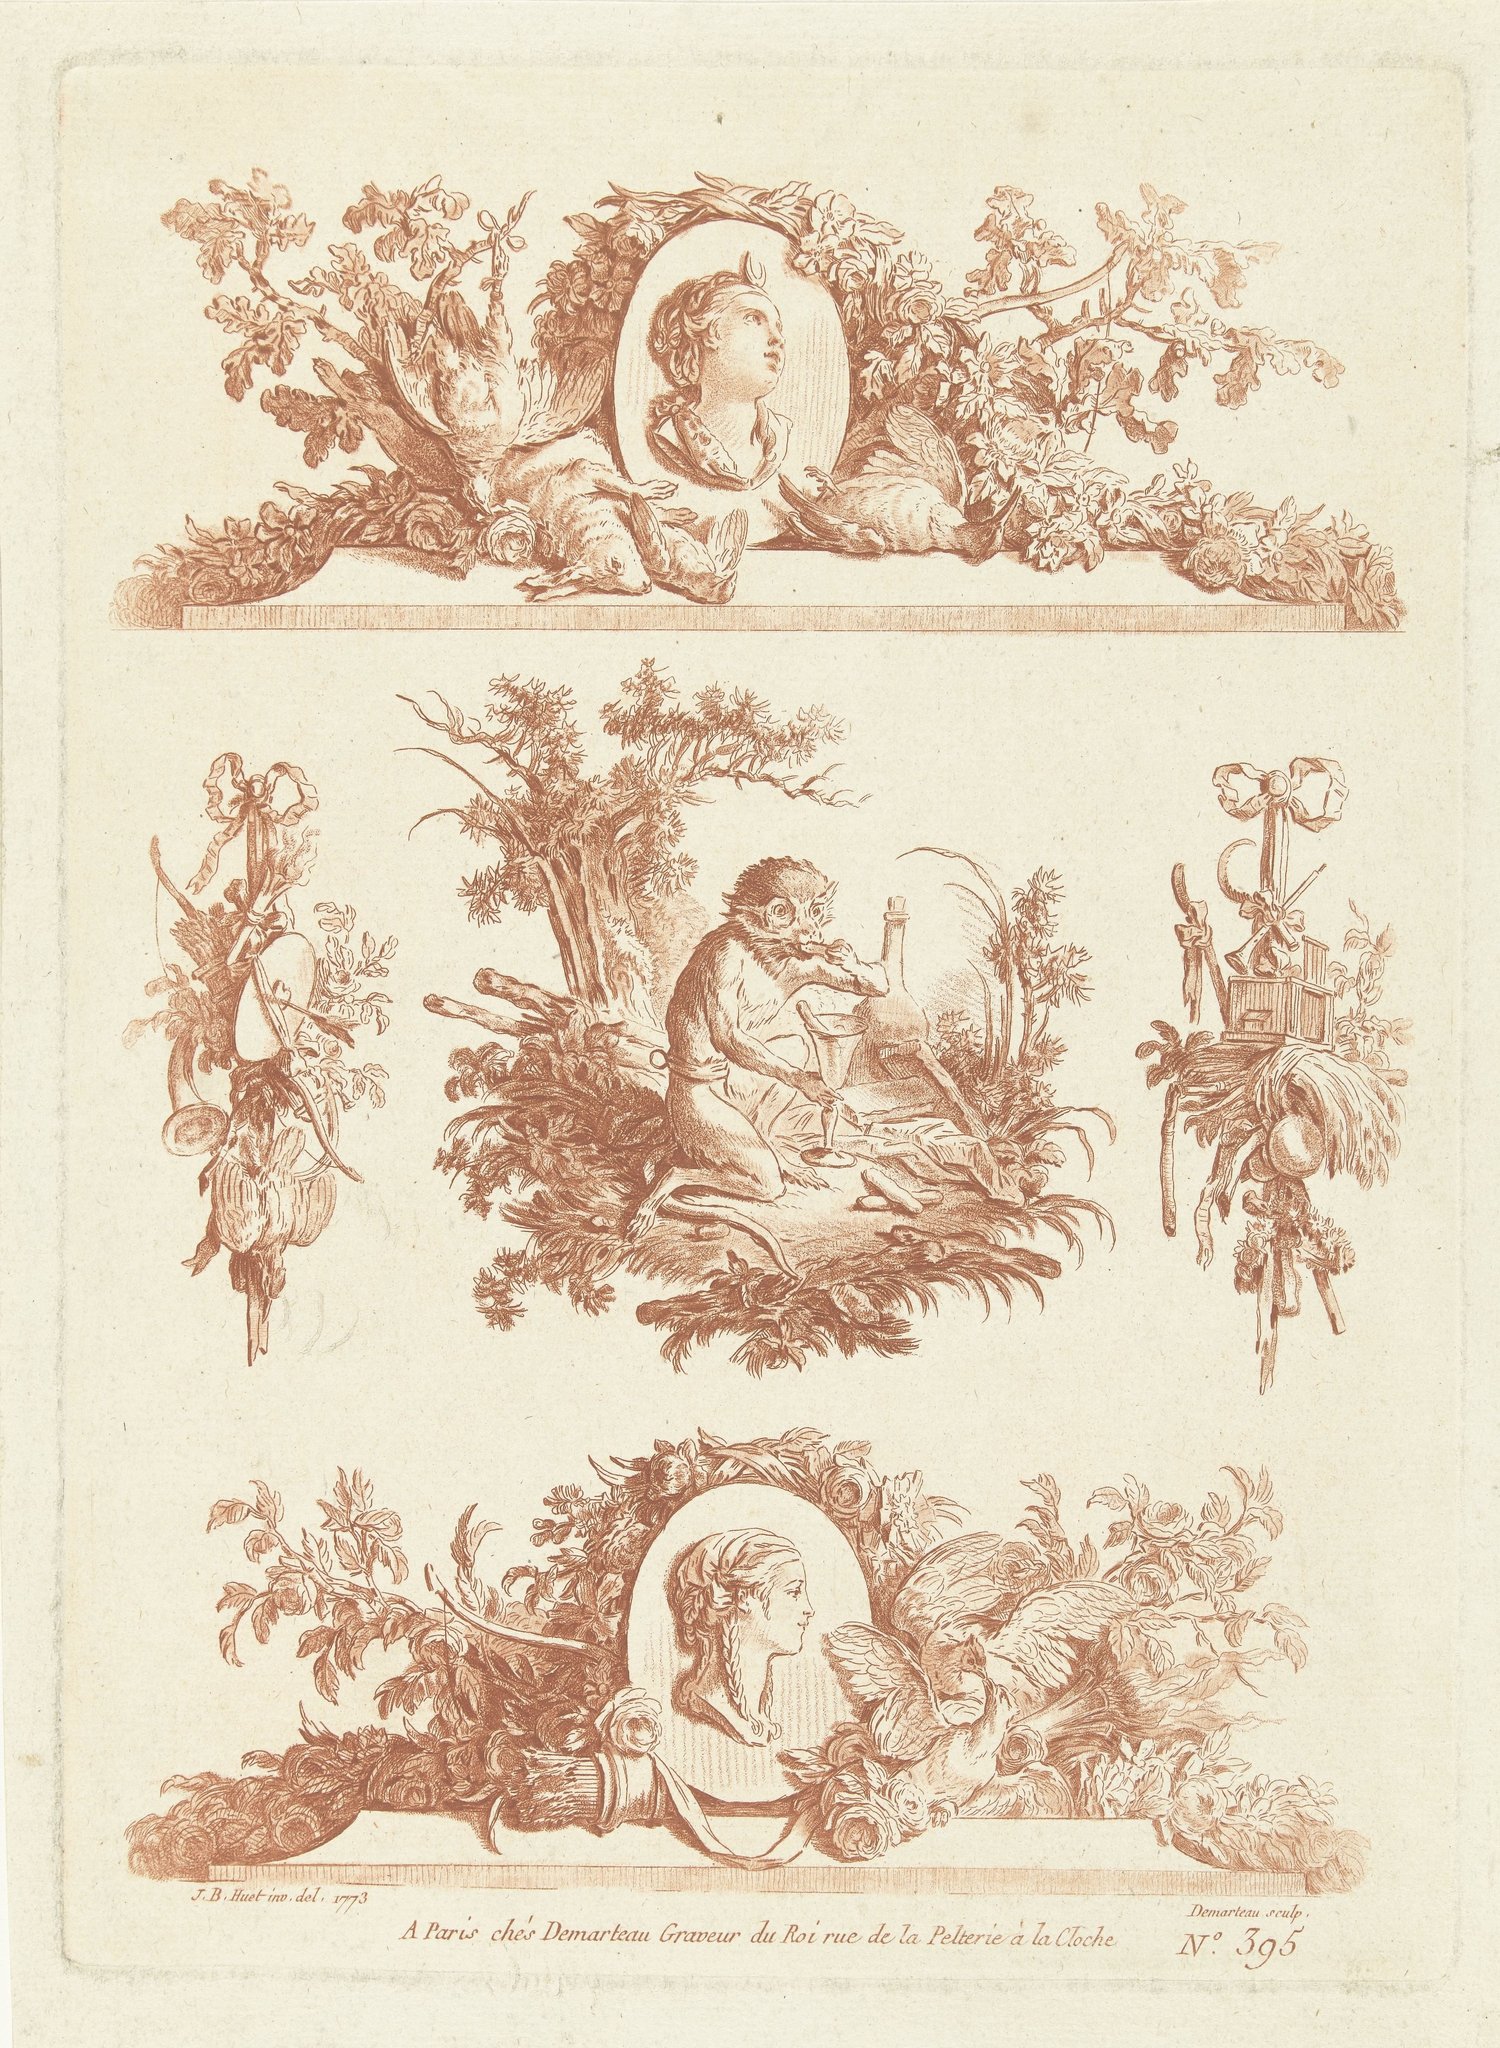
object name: print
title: Studieblad met vijf vignetten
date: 1773-1776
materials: paper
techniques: printmaking, etching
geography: paris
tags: (story of) diana (artemis), monkeys, apes, spoils of the hunt, game, venison, other birds: turtle dove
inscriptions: collector's mark: Lugt 2228